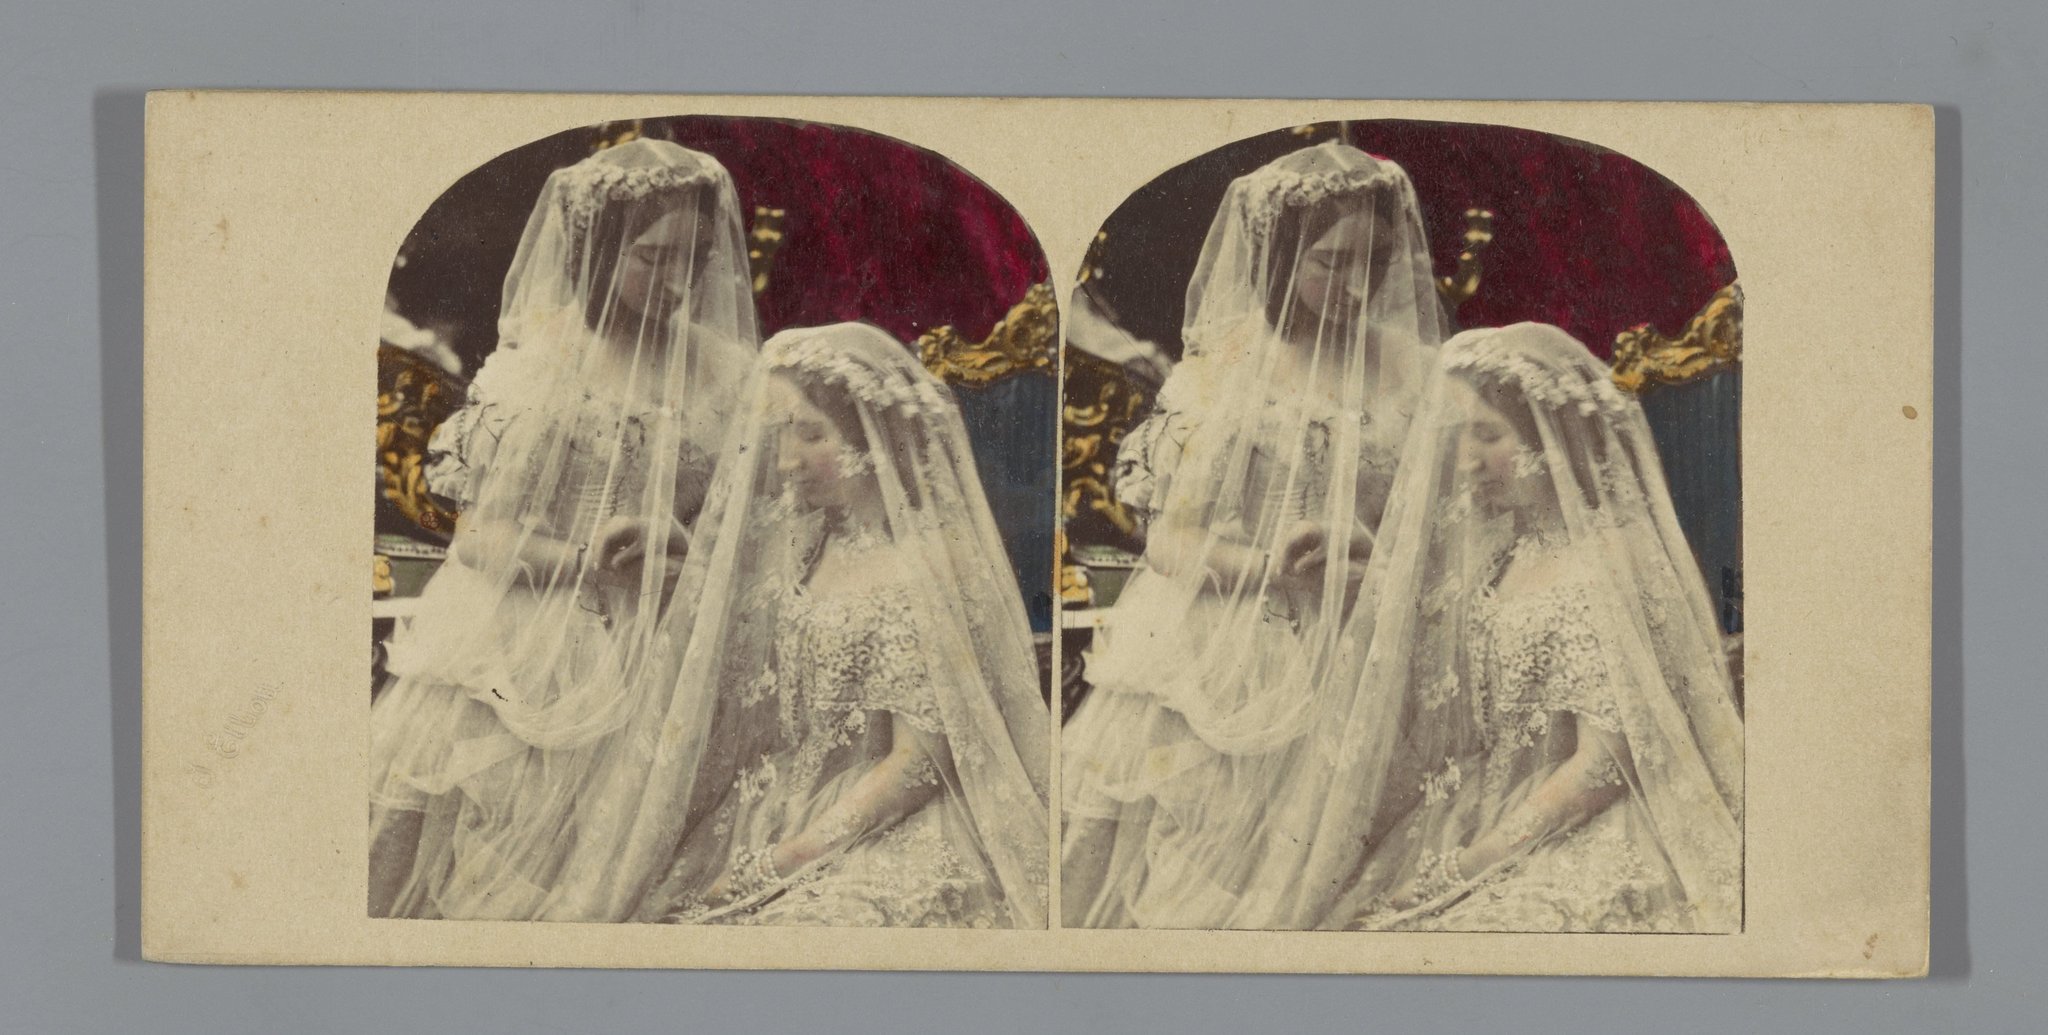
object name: stereograph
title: Twee bruiden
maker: james elliott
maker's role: publisher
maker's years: 1832-1900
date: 1856-1861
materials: cardboard, paper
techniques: albumen print, hand coloring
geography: london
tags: bride (in wedding-dress)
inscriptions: inscription: ‘& ru f 1,75’